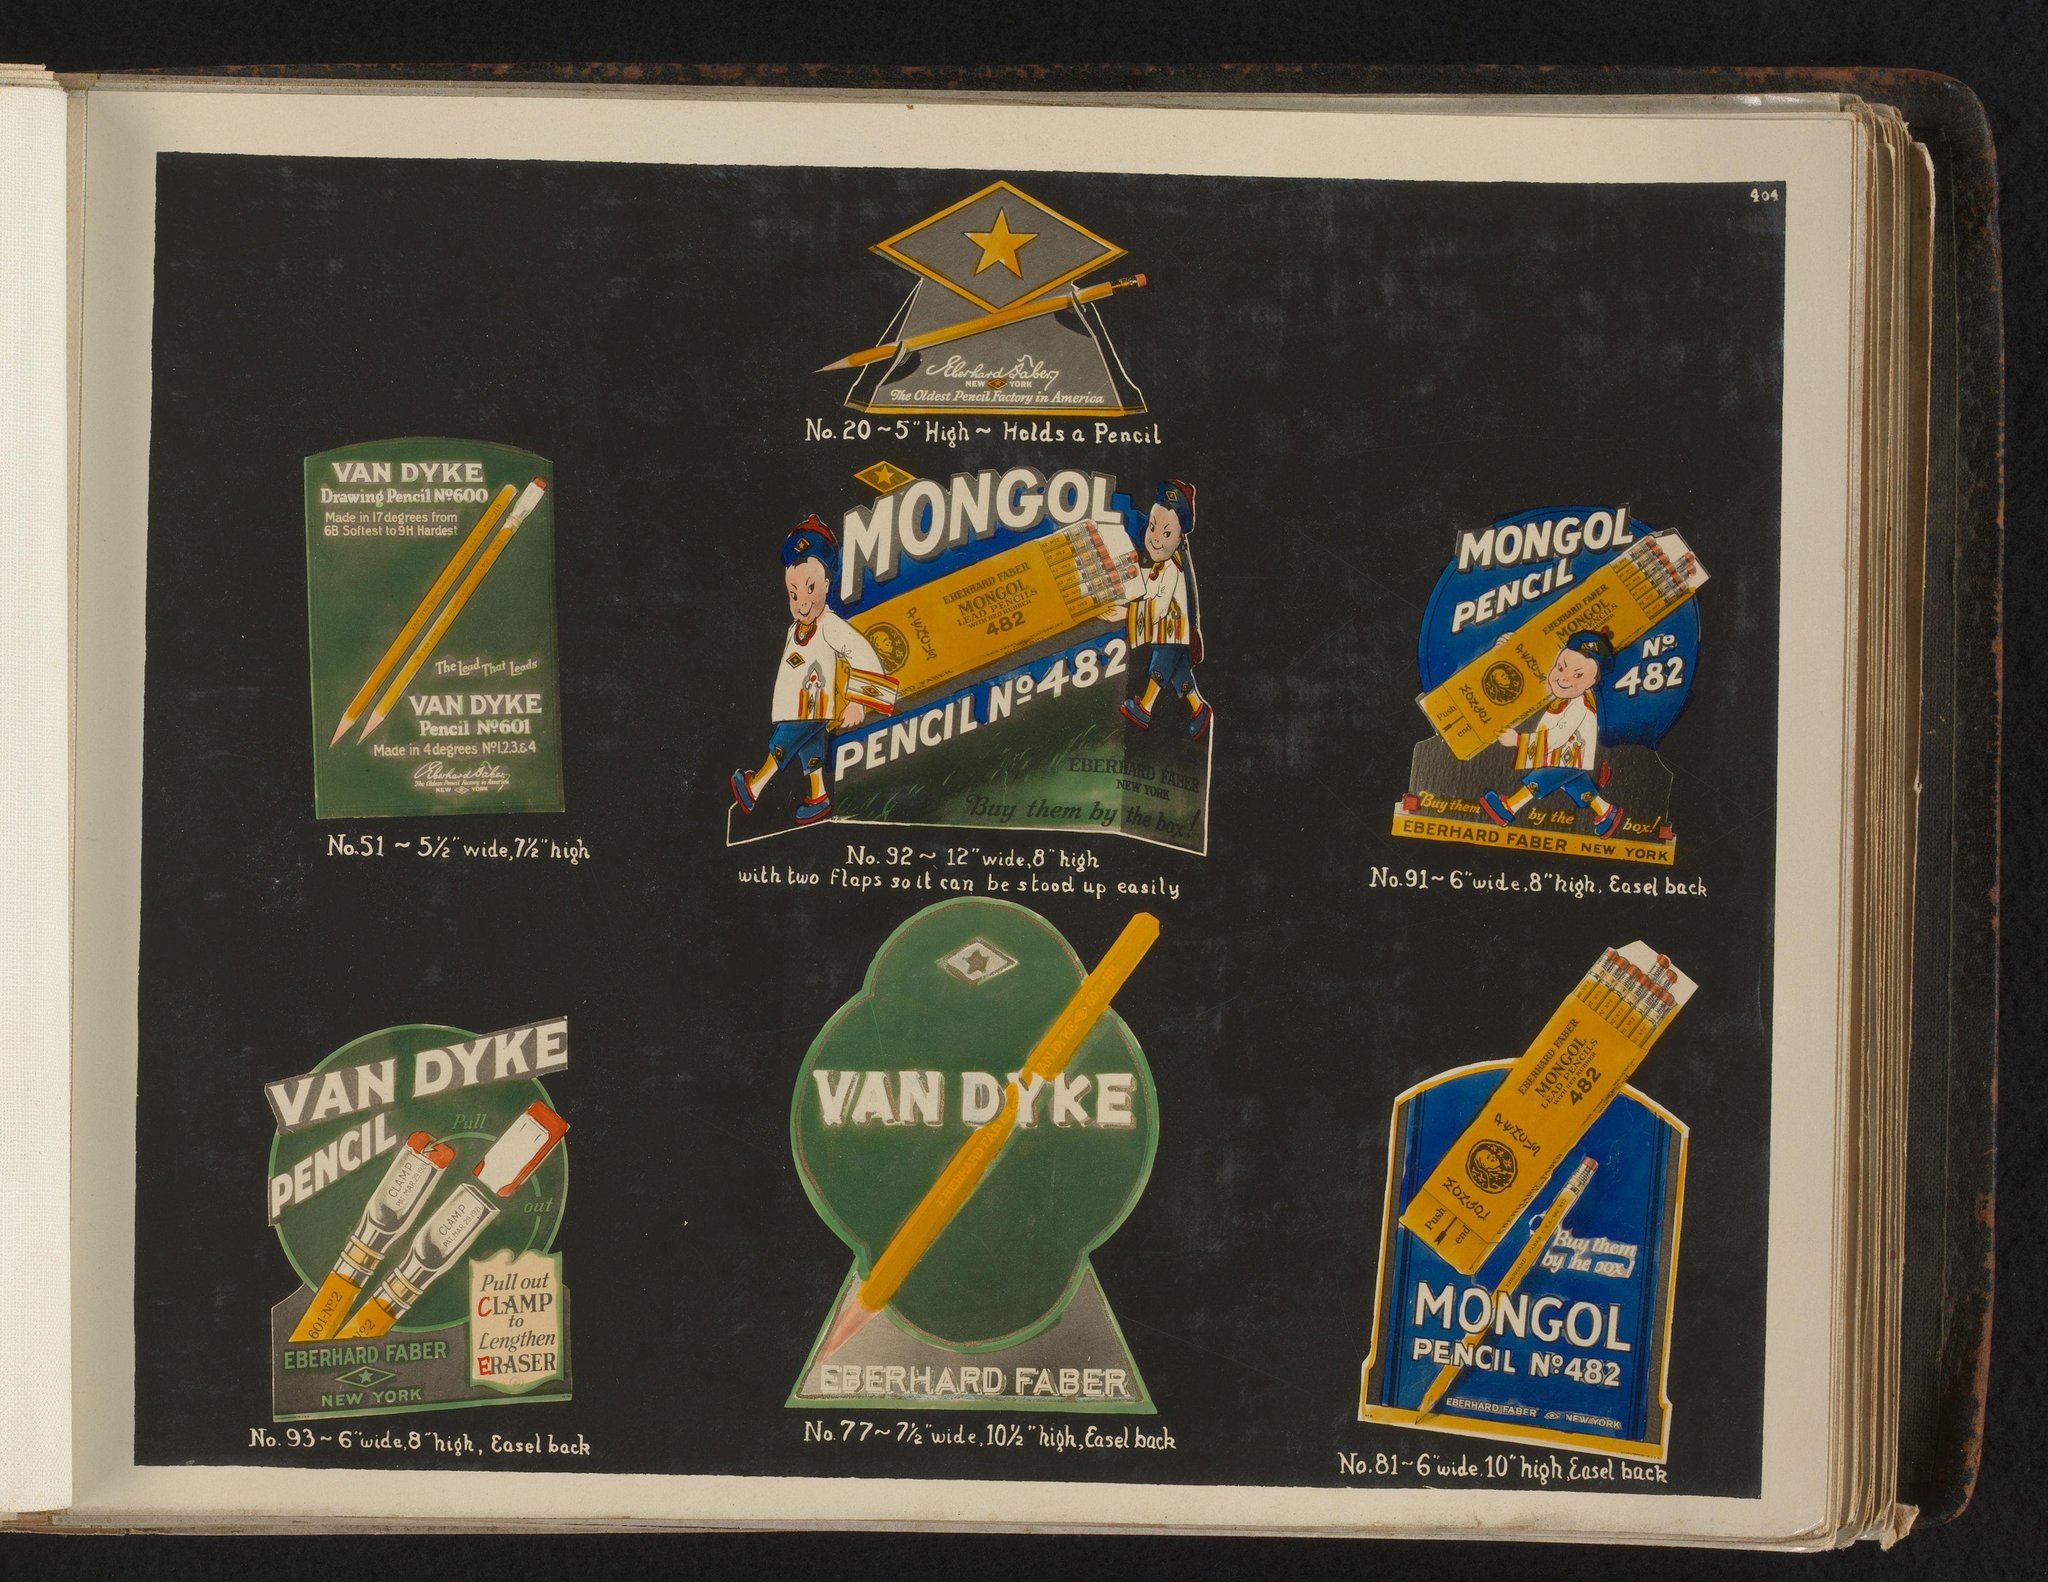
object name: album leaf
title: Reclamemateriaal voor potloden van Eberhard Faber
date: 1915-1935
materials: paper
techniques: gelatin silver print, hand coloring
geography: springfield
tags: pencil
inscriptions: number: ‘404’, stamp: ‘Paramount/ Commercial Studios/ 145 Chestnut St./ Springfield - Mass.’